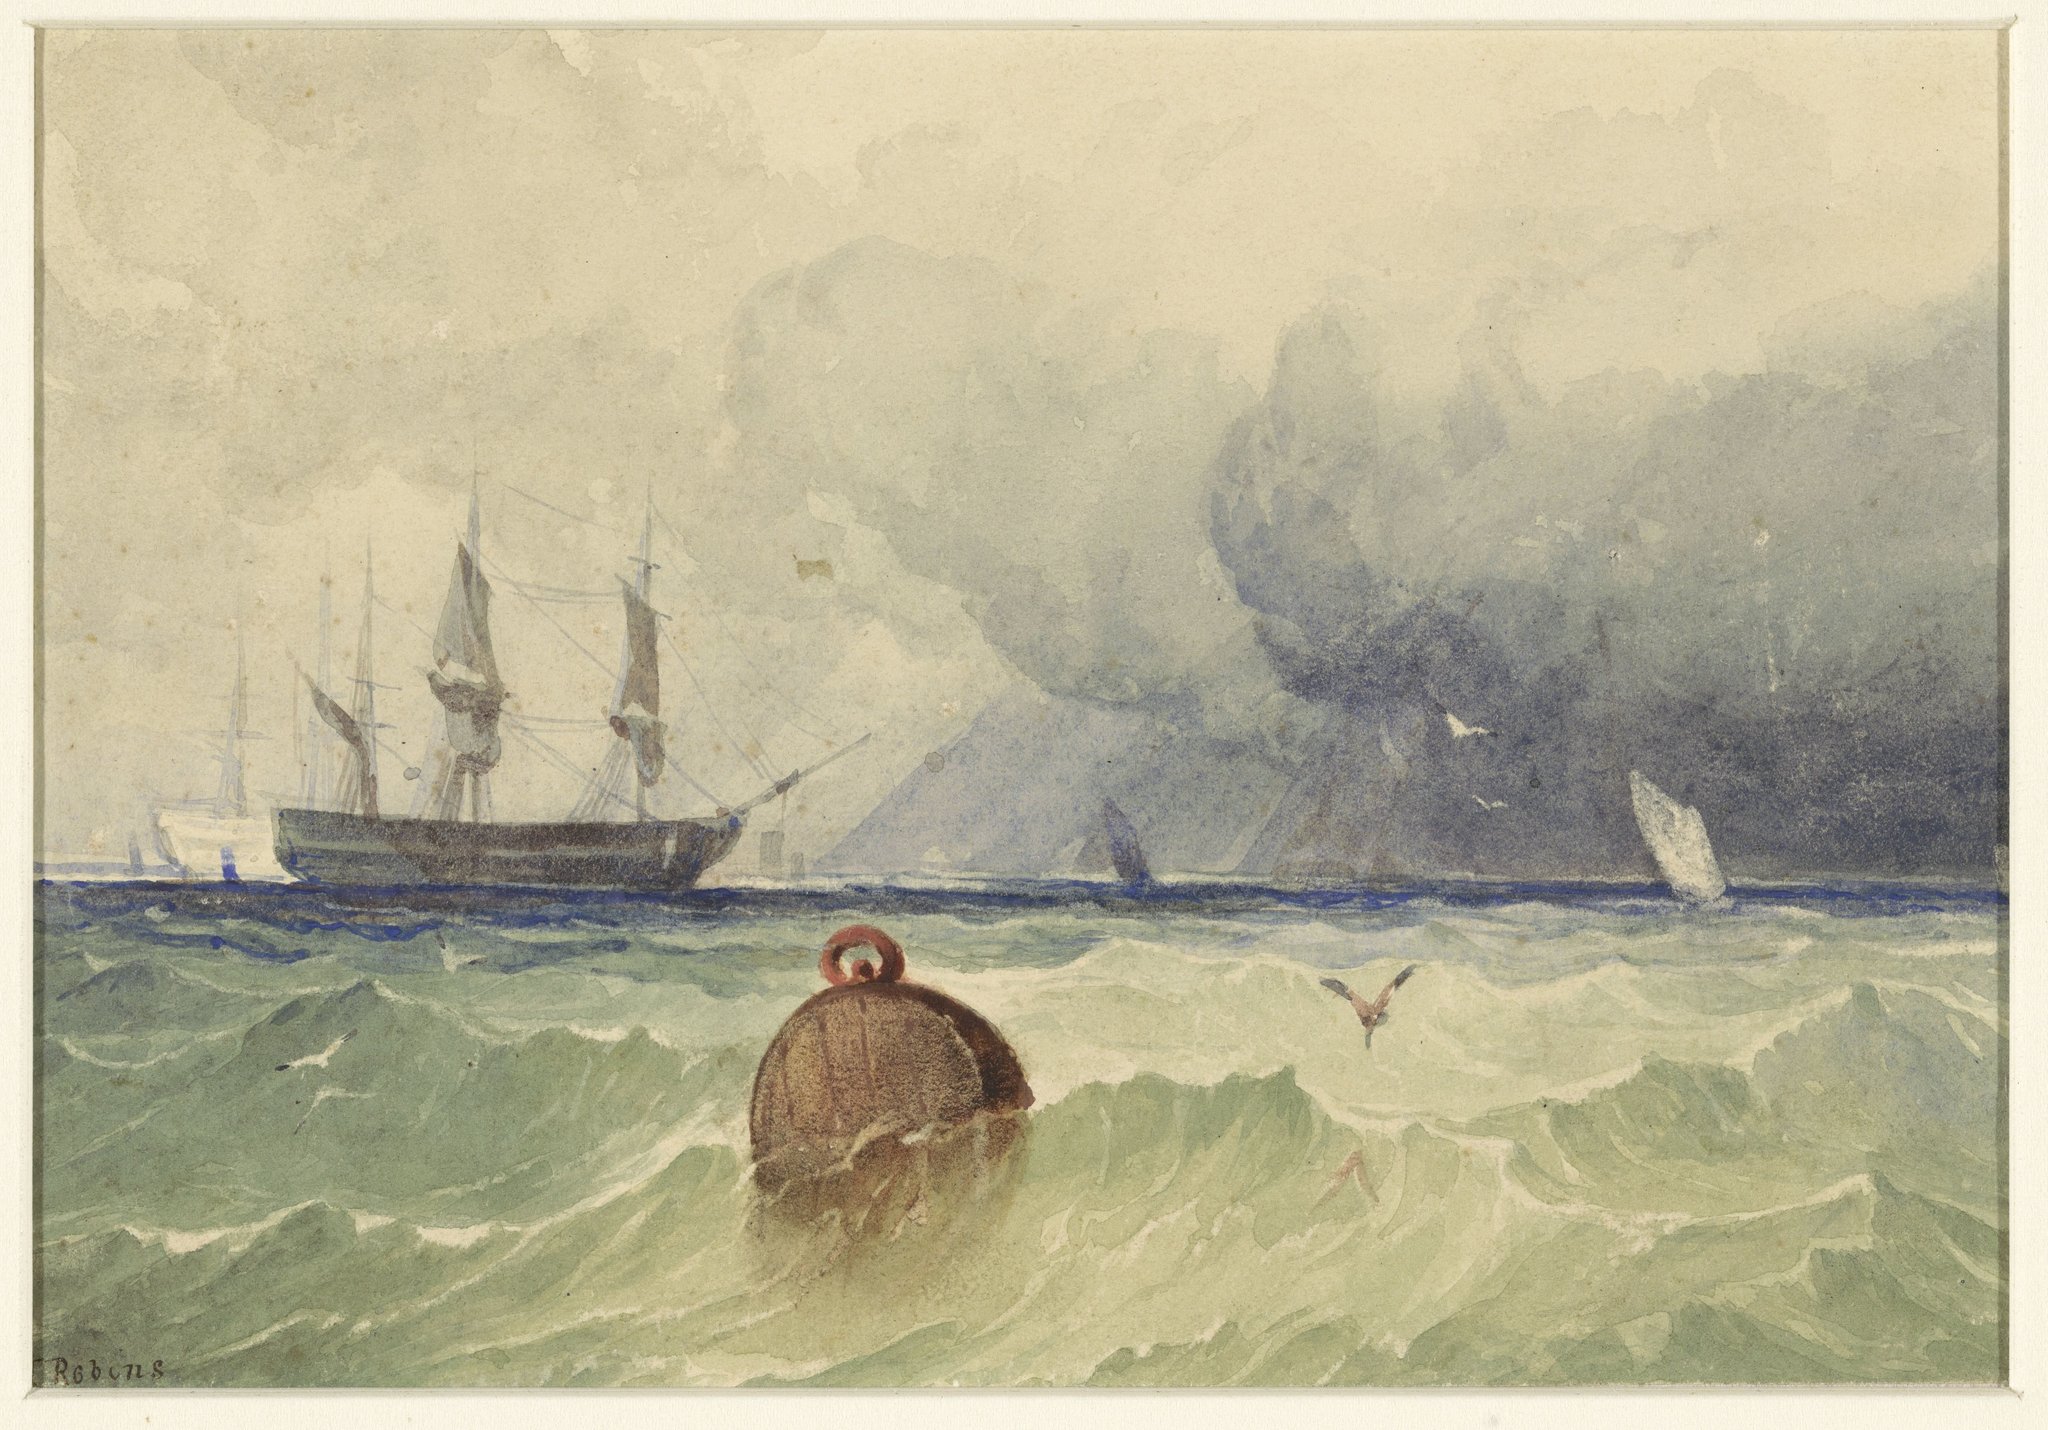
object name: drawing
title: Driemasters voor anker bij opkomend zwaar weer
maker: thomas sewell robins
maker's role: draughtsman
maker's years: 1814-1880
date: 1830-1880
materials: paper, watercolor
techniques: brush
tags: sailing-ship, sailing-boat, sea (seascape) (+ landscape with figures, staffage)